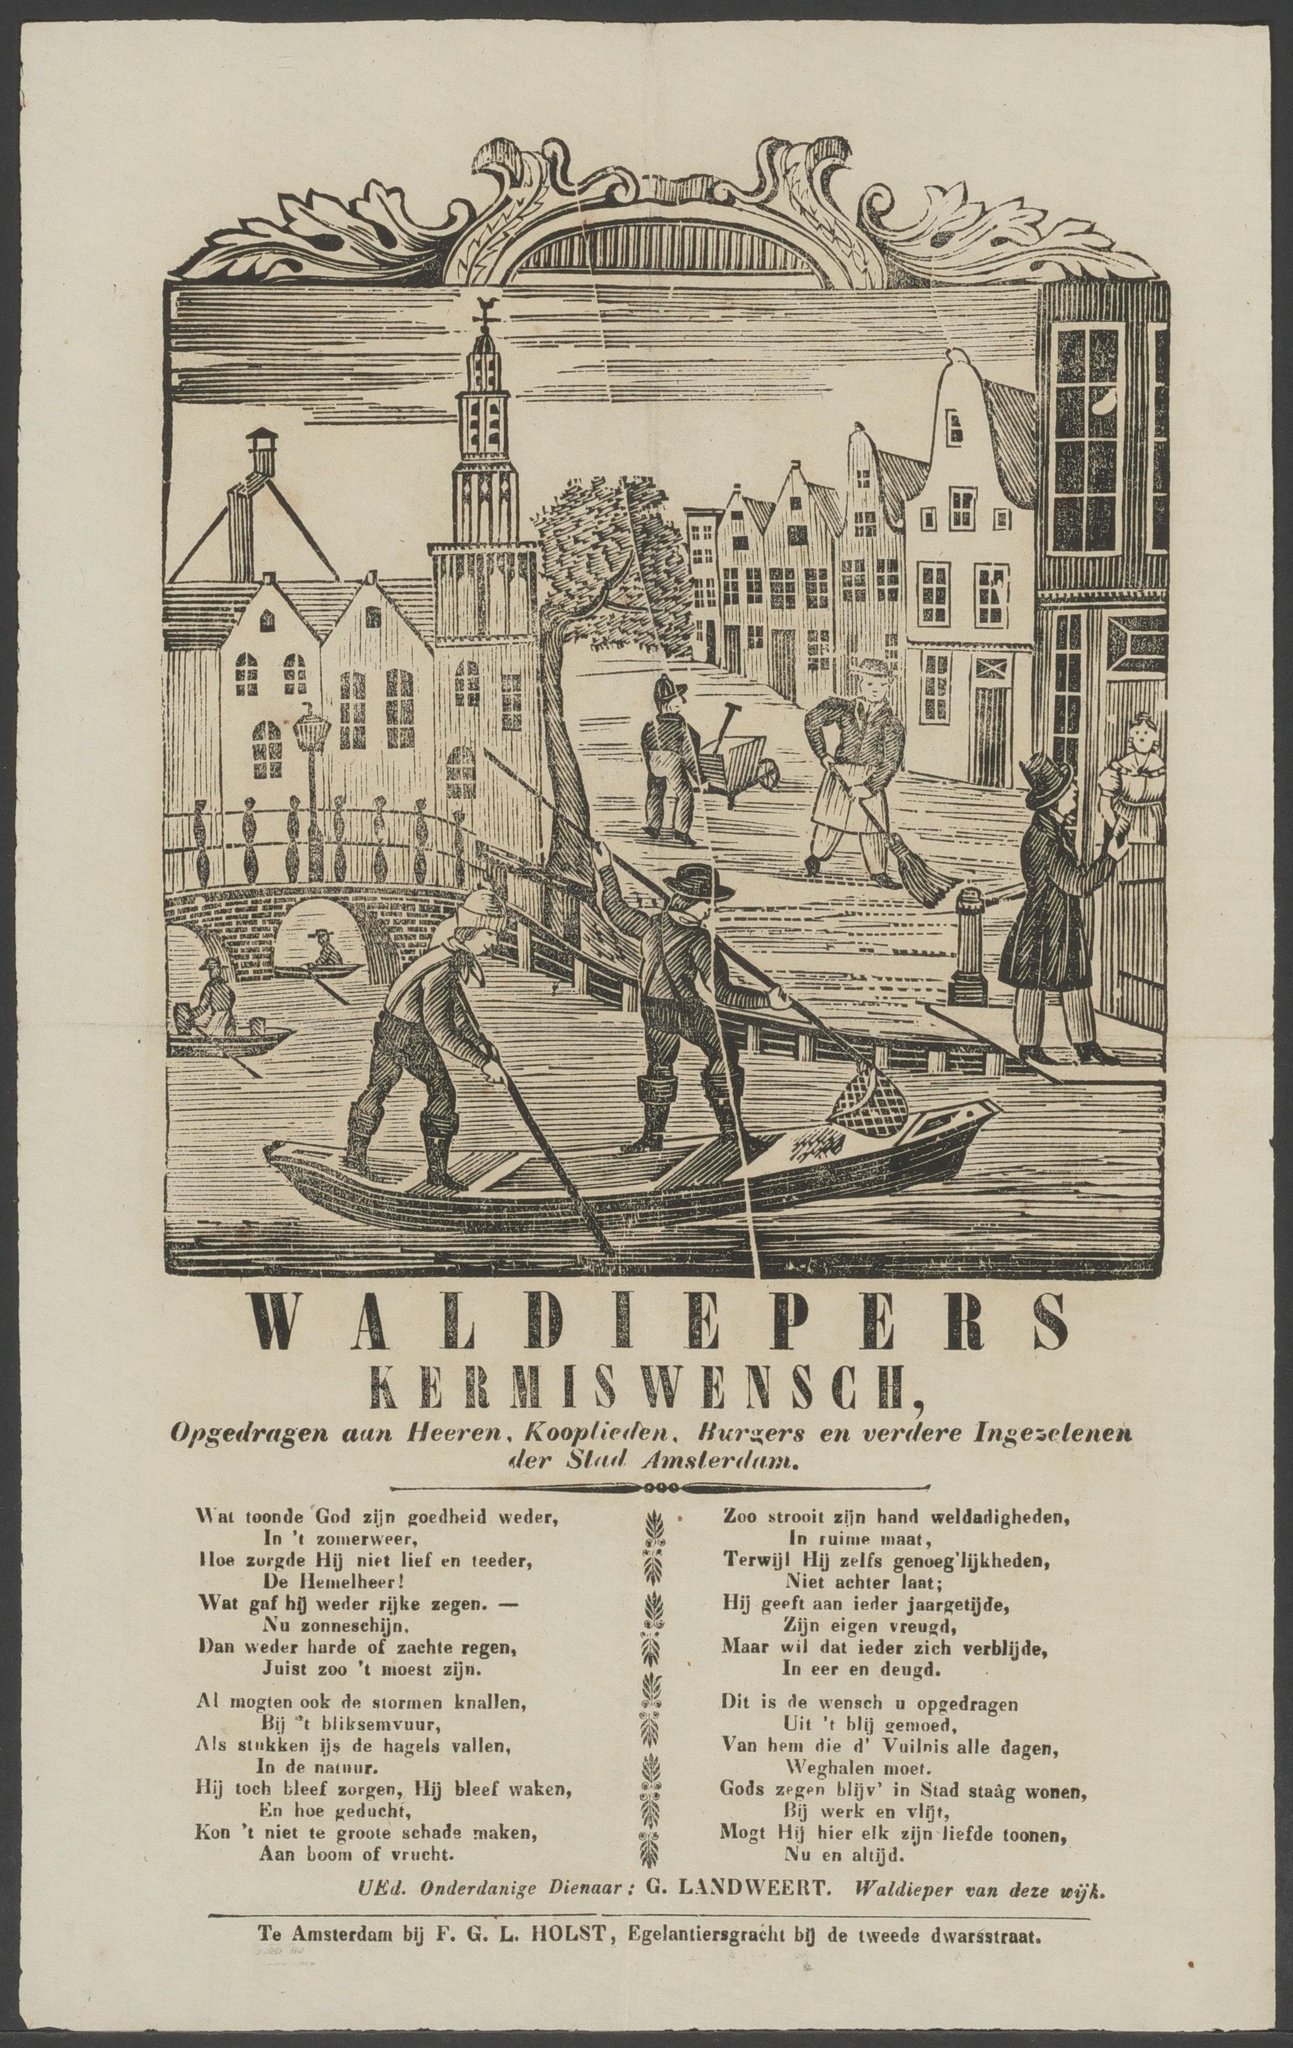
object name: new year card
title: Nieuwjaarswens van de Amsterdamse waldiepers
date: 1841-1864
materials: paper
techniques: letterpress printing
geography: amsterdam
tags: dredging (industrial process), canal, bridge in city across river, canal, etc., amsterdam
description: Nieuwjaarswens van de Amsterdamse waldiepers (baggeraars). Gezicht op een Amsterdamse gracht waar twee mannen in een schuit bezig zijn de gracht uit te diepen, een andere man haalt bij een huis geld op. Met een vers in twee kolommen. Namens de waldieper G. Landweert. Onderwerpsrubrieken binnen de Atlas Zeden en Gewoonten: Zeden en gewoonten in engeren zin, Volksleven, Volksbladen, Nieuwjaars- en Kerstwenschen, Amsterdam.